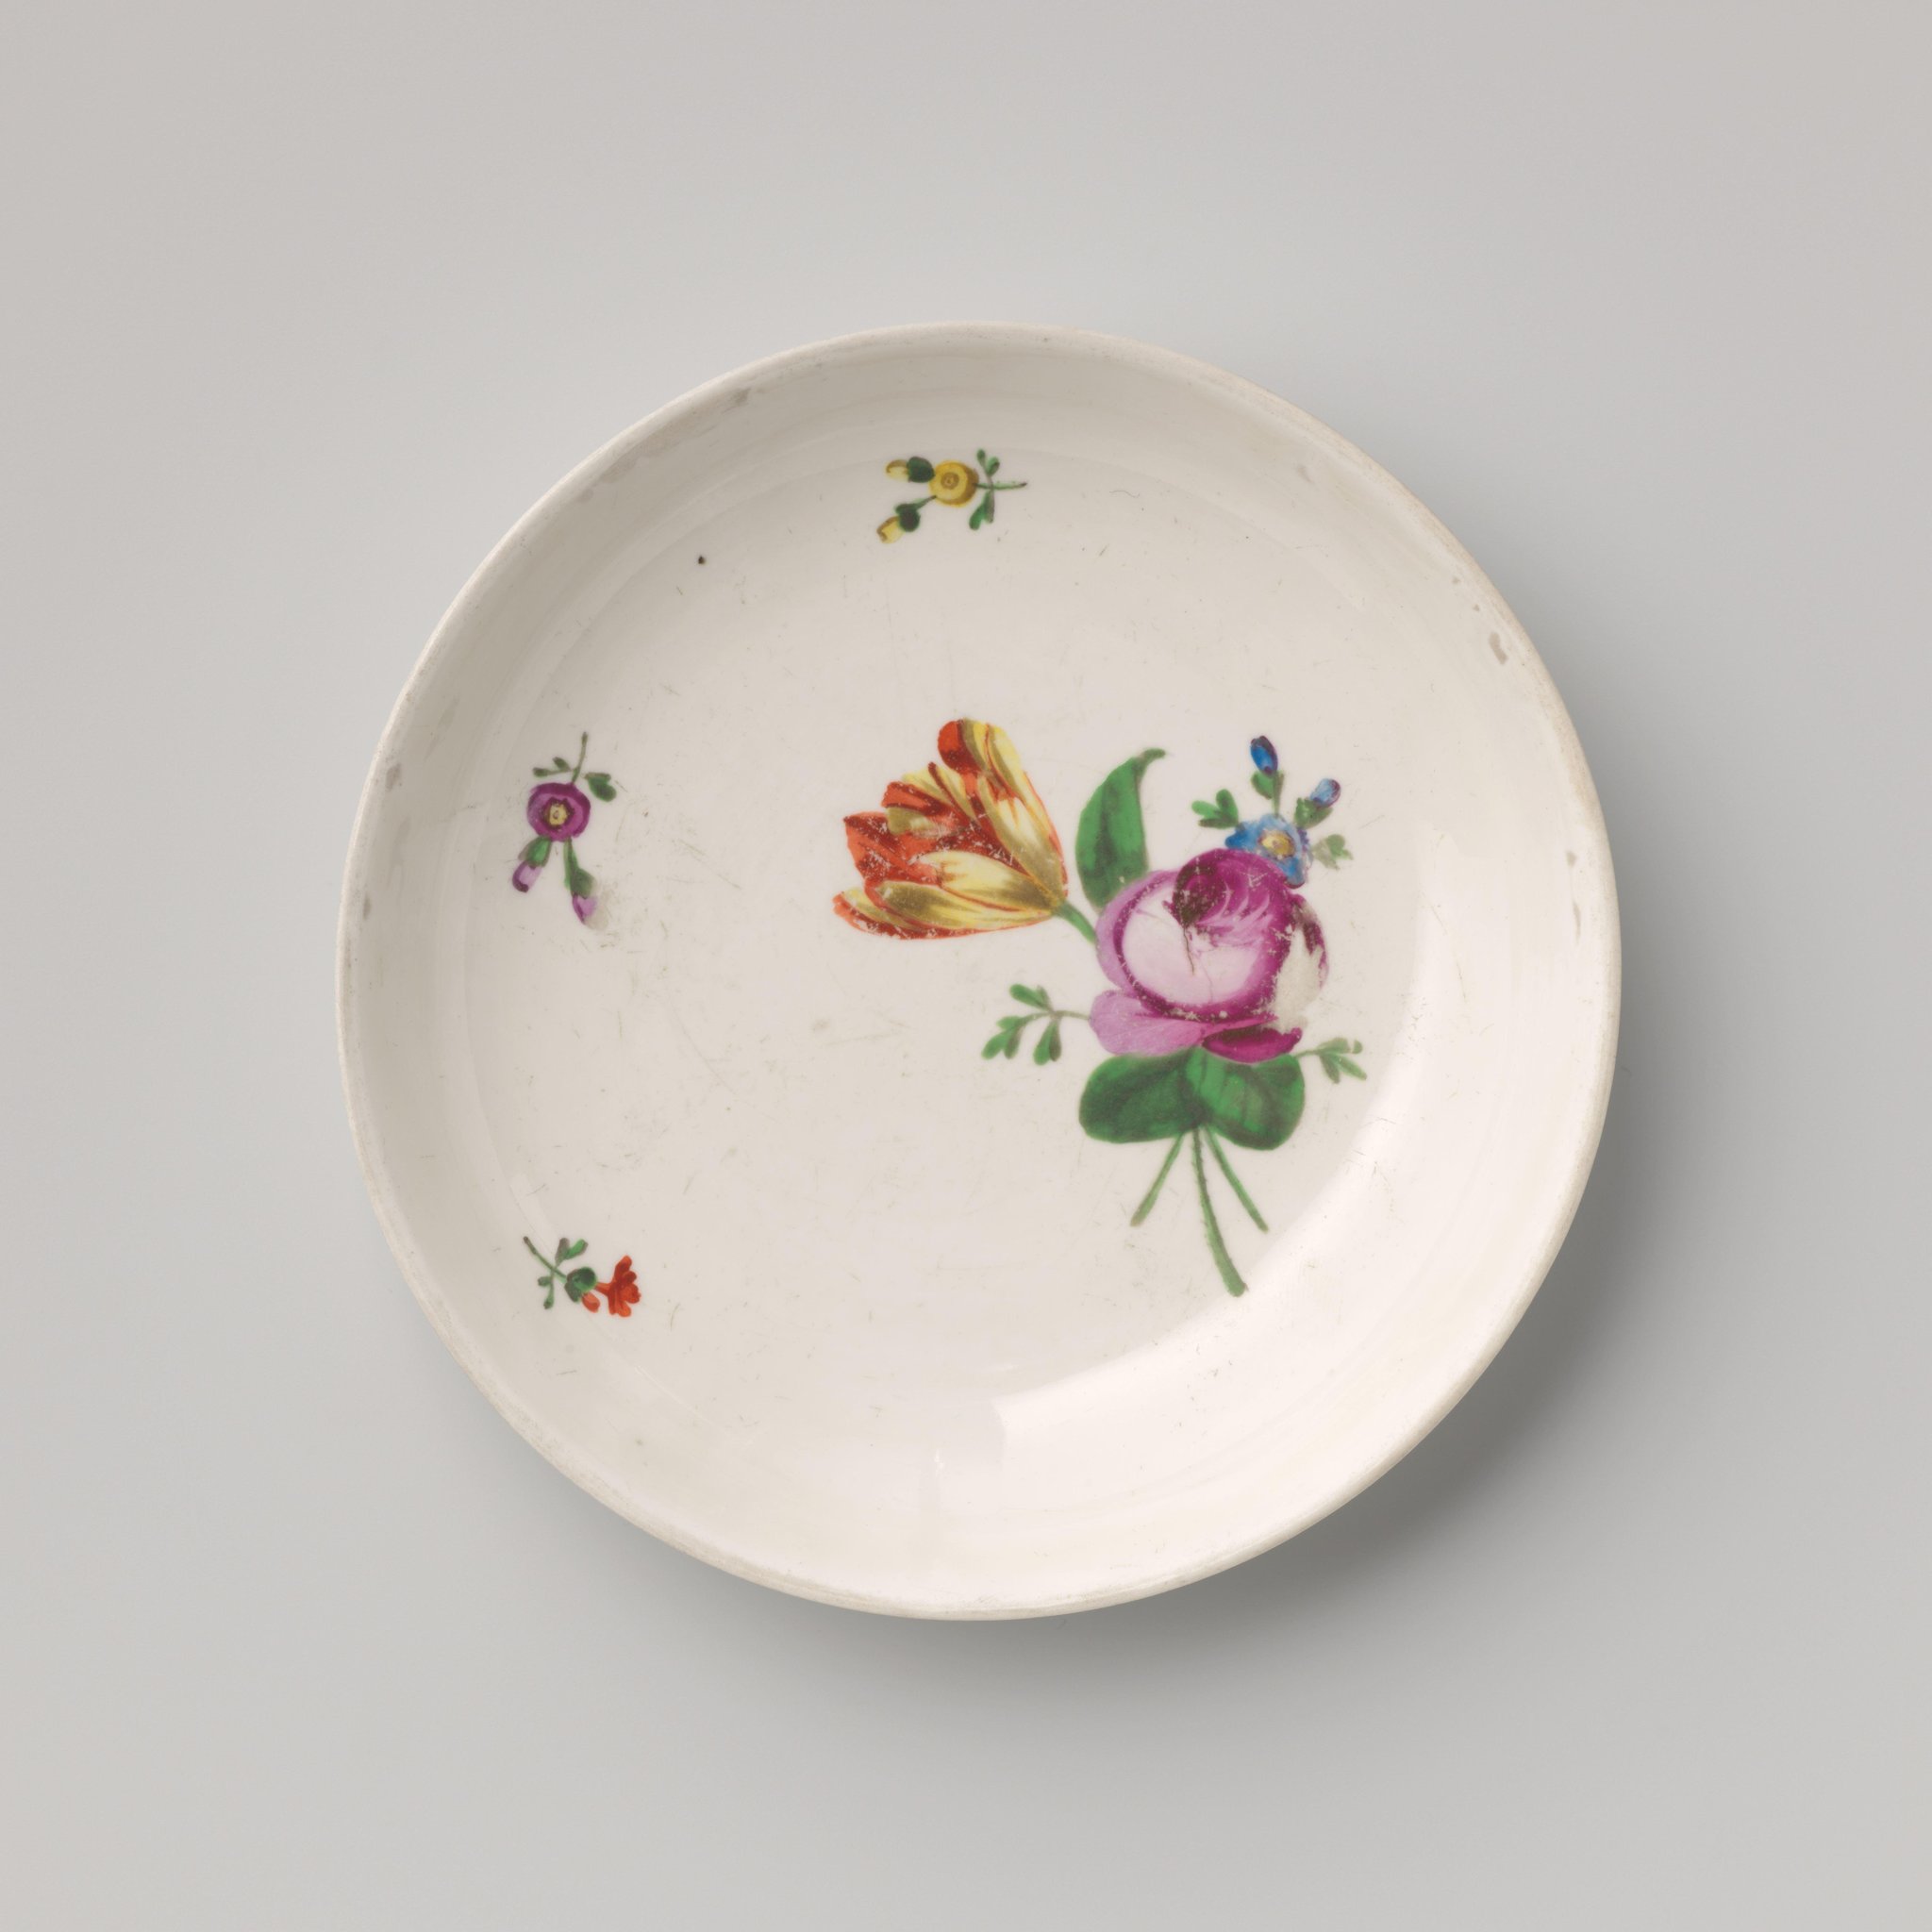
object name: service set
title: Saucer with a bouquet and flower sprays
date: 1809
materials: glaze, paint, porcelain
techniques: firing, forming, turning, vitrification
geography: vienna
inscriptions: mark: ‘schild/ A/ 90/ 12/ 809’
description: Schotel van porselein met een gelobde rand, beschilderd op het glazuur in blauw, rood, roze, groen en geel. Op het plat een boeket van verschillende bloemen (o.a. pioenroos) omgeven door bloemtakken. Gemerkt op de onderzijde met het schild, de letter A en de nummers 90, 12 en het jaarnummer 809.